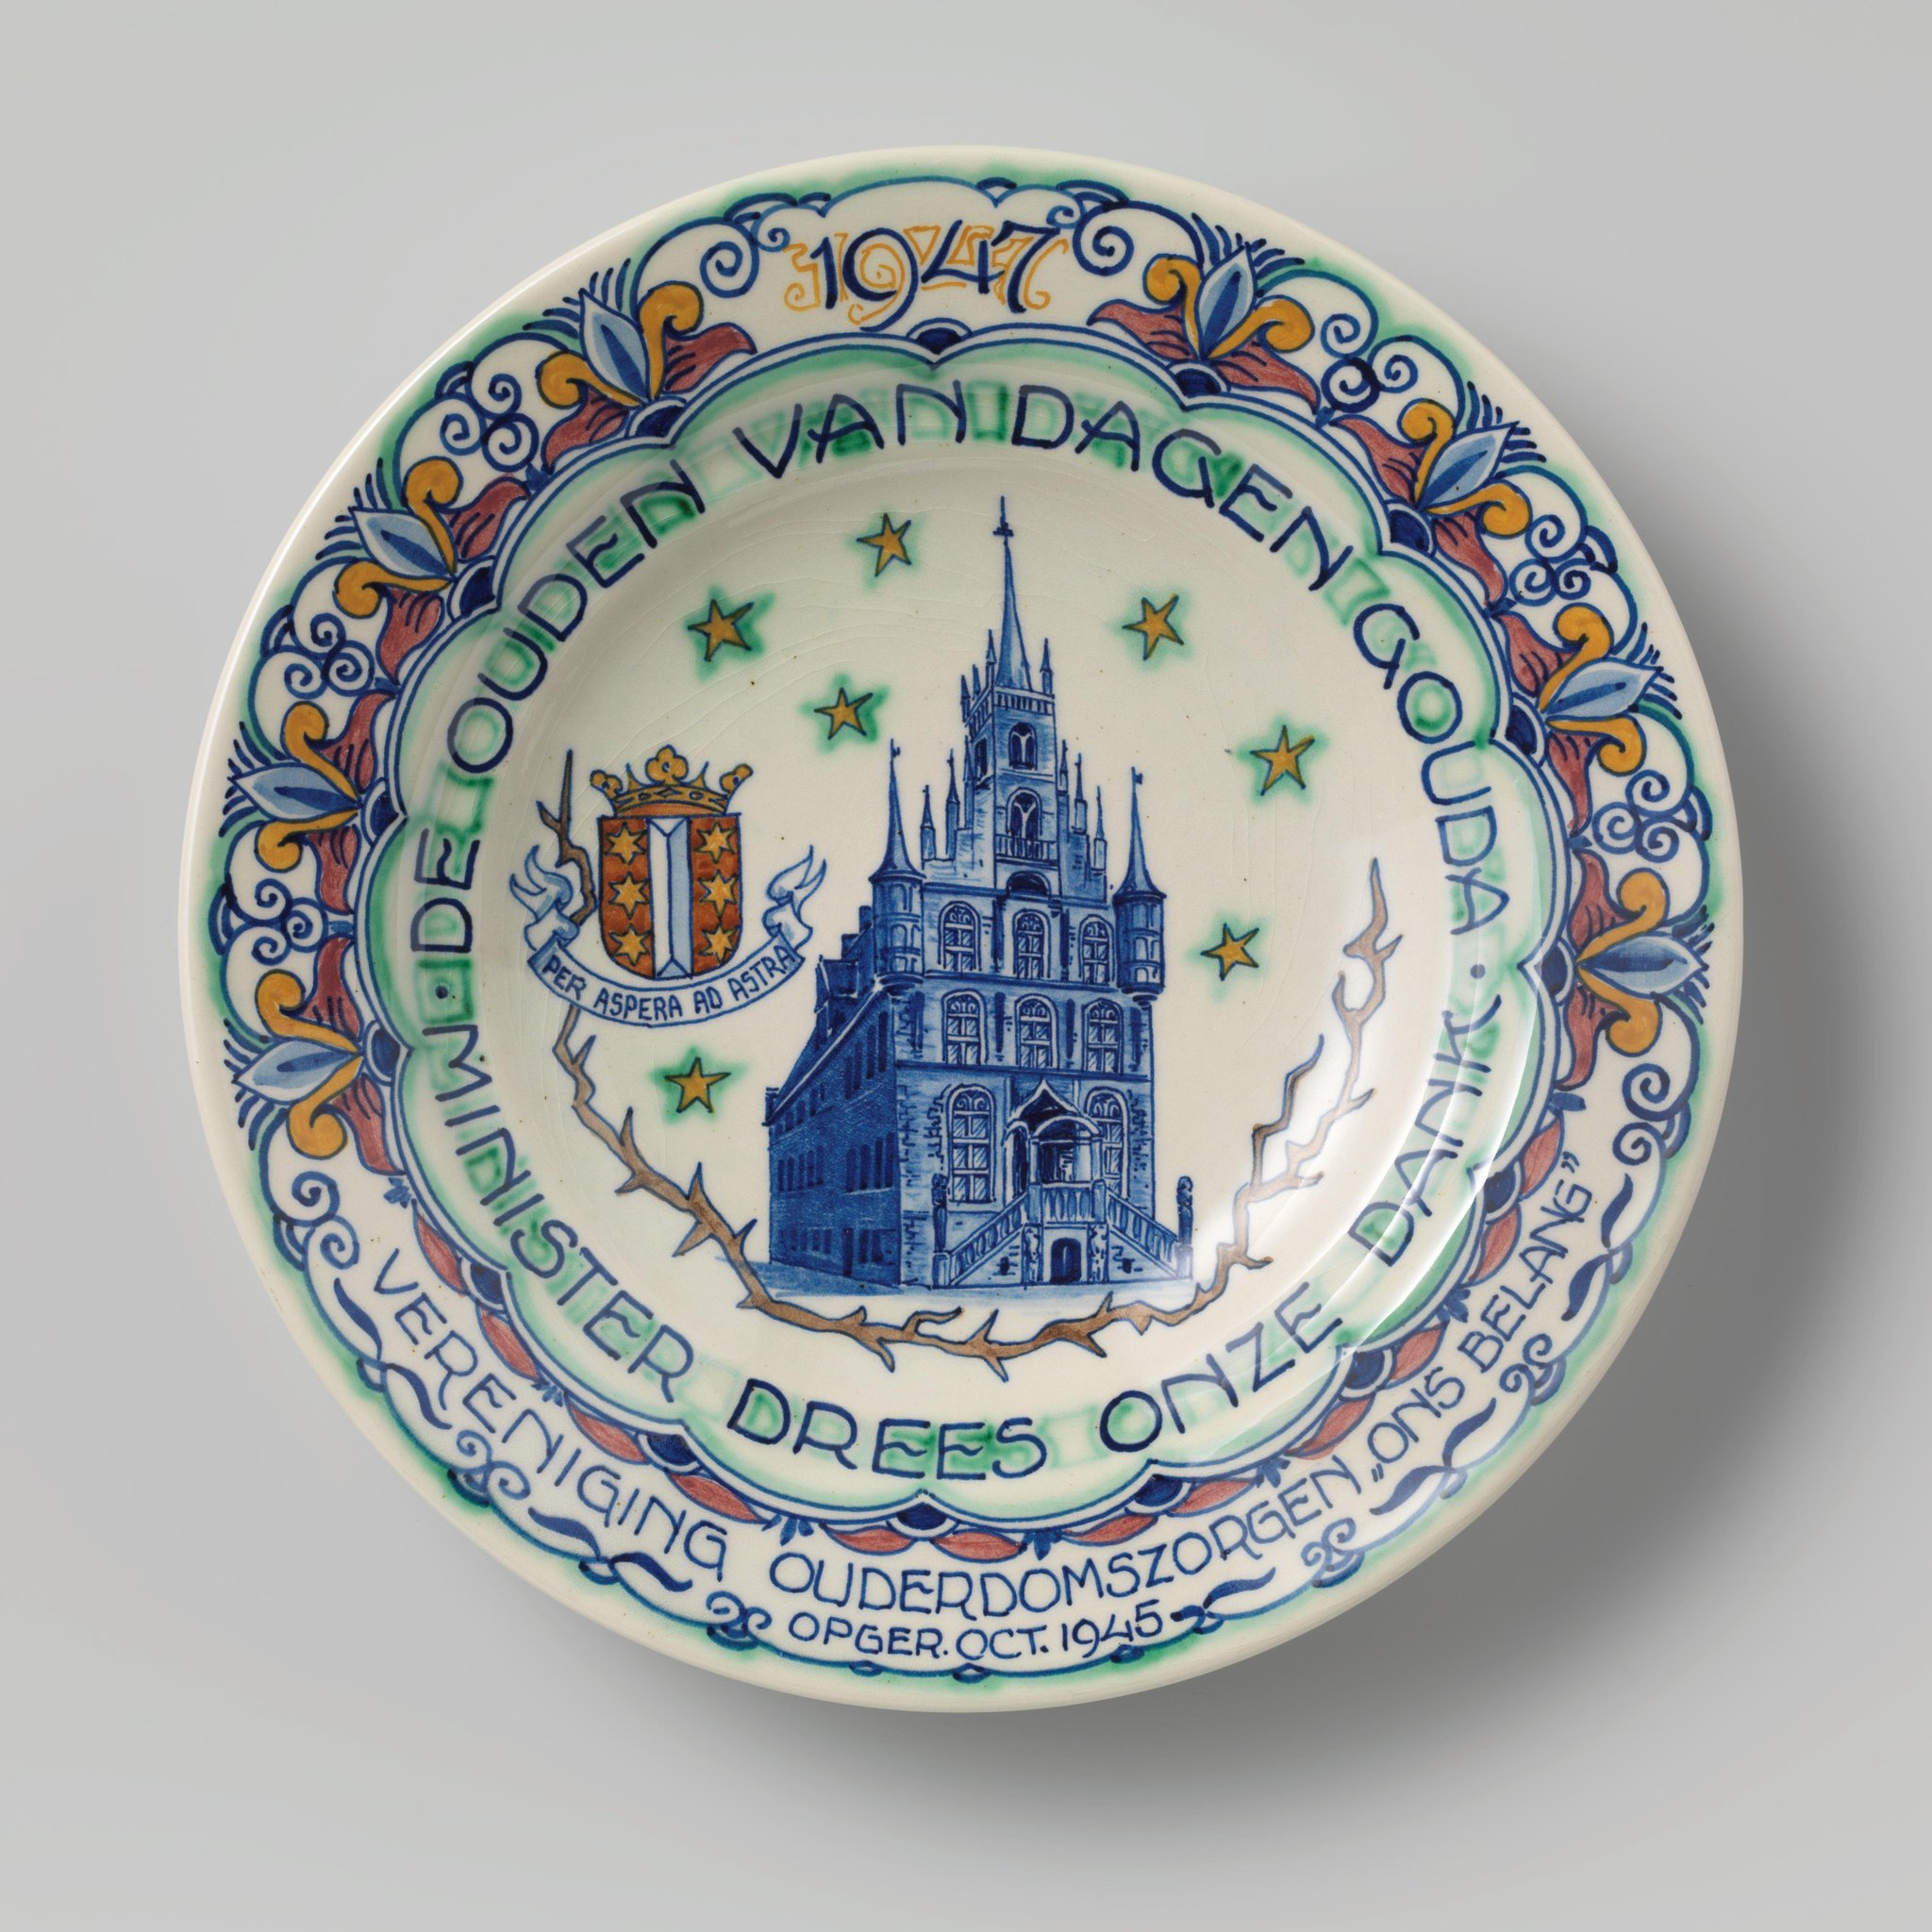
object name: herinneringsbord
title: Wandbord door de Vereniging Ouderdomszorgen 'Ons belang' aangeboden aan Dr W. Drees, minister van sociale zaken, 1947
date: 1947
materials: creamware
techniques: firing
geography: gouda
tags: amsterdam, the hague, willem drees, townhall, netherlands, gouda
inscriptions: number: ‘1752’, factory mark: ‘Koninklijk Goedewaagen Gouda’, inscription: ‘DE OUDEN VAN DAGEN GOUDA MINISTER DREES ONZE DANK’, inscription: ‘Aangeboden aan zijne Excellentie W. Drees minister v. Sociale Zaken’, inscription: ‘1947 VERENIGING OUDERDOMSZORGEN "ONS BELANG" OPGER. OCT. 1945’, inscription: ‘PER ASPERA AD ASTRA’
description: Wandbord van Engels aardewerk Gouda, Koninklijke Hollandsche Pijpen- en Aardewerkfabriek Geodewaagen N.V., 1947 Geschenk J.M. en dr W. Drees. Den Haag, 1991 Dit bord, dat in 1947 aan minister Drees is aangeboden, maakt deel uit van een grote schenking persoonlijke herinneringen van deze beroemde staatsman.